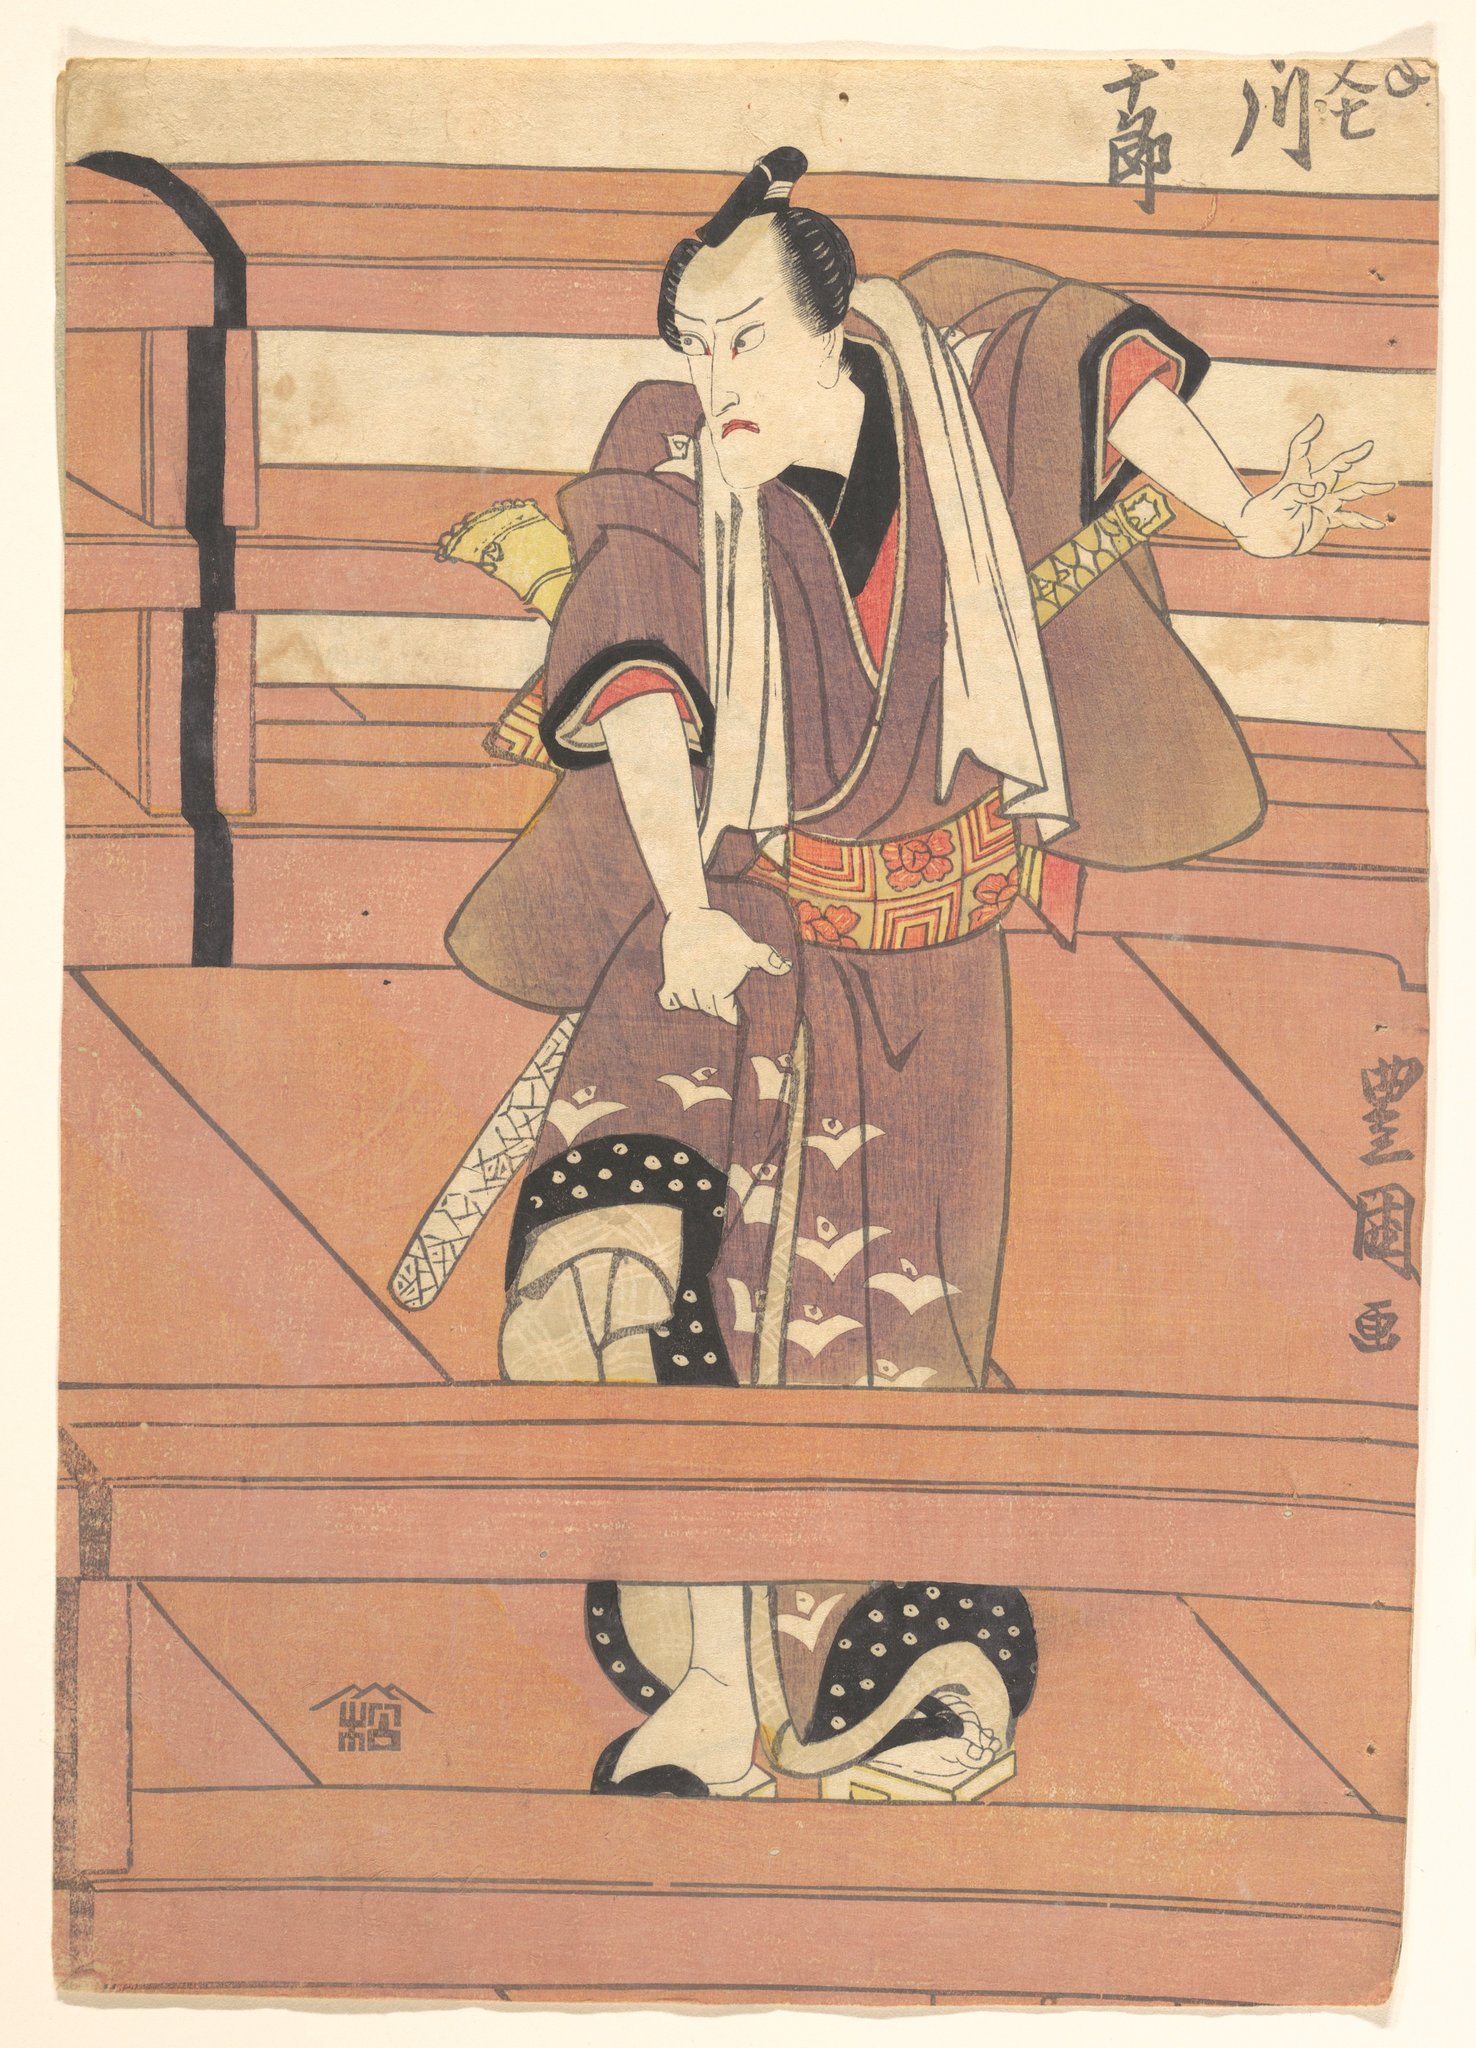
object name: print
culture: japanese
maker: utagawa kunisada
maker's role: artist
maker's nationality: japanese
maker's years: 1786-1864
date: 1801-1900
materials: ink, paper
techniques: woodblock print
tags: men